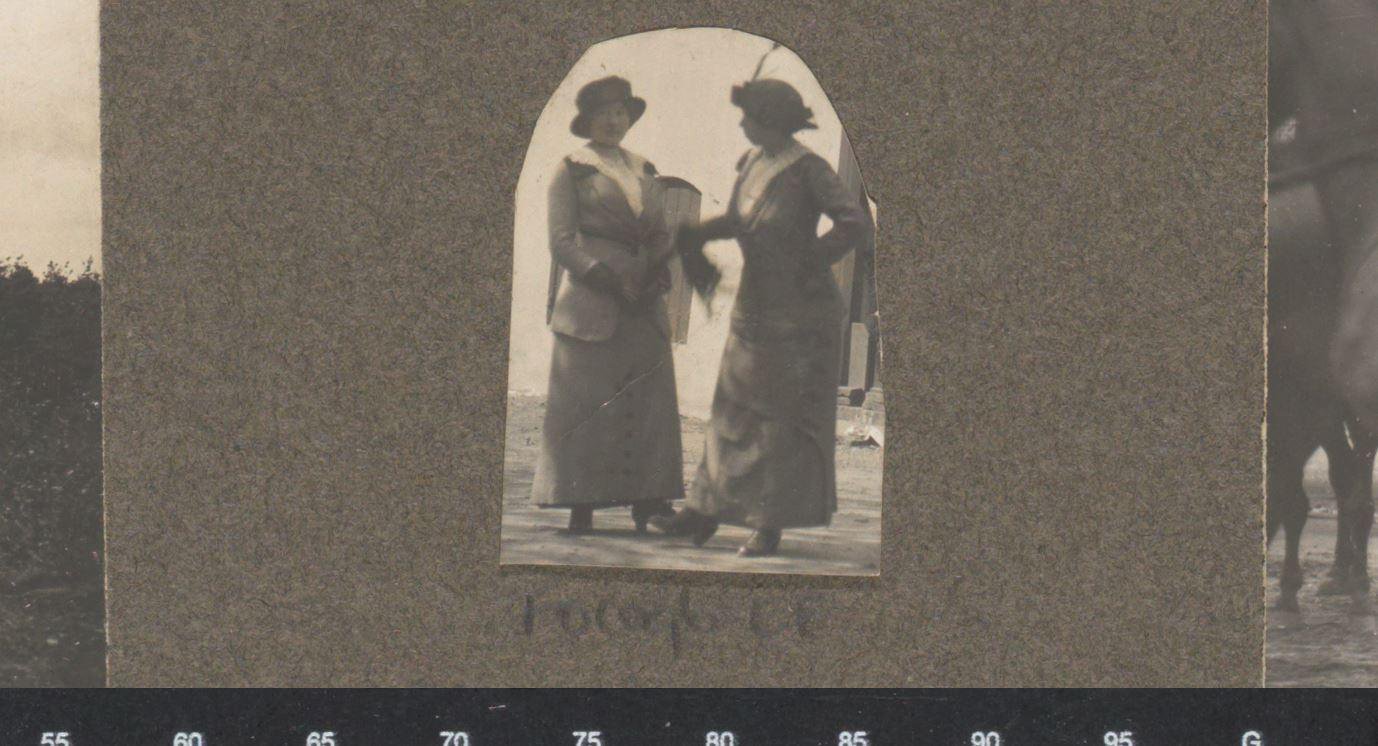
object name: photograph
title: Ruitertafereel op Koninklijke Houtvesterij Het Loo: twee staande vrouwen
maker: Anonymous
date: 1900-1925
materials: photographic support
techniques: gelatin silver print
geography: het loo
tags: adult woman, hunting, chase, hunting-ground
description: Onderdeel van Fotoalbum van de heer Brams, opperhoutvester van koningin Wilhelmina op Koninklijke Houtvesterij Het Loo.